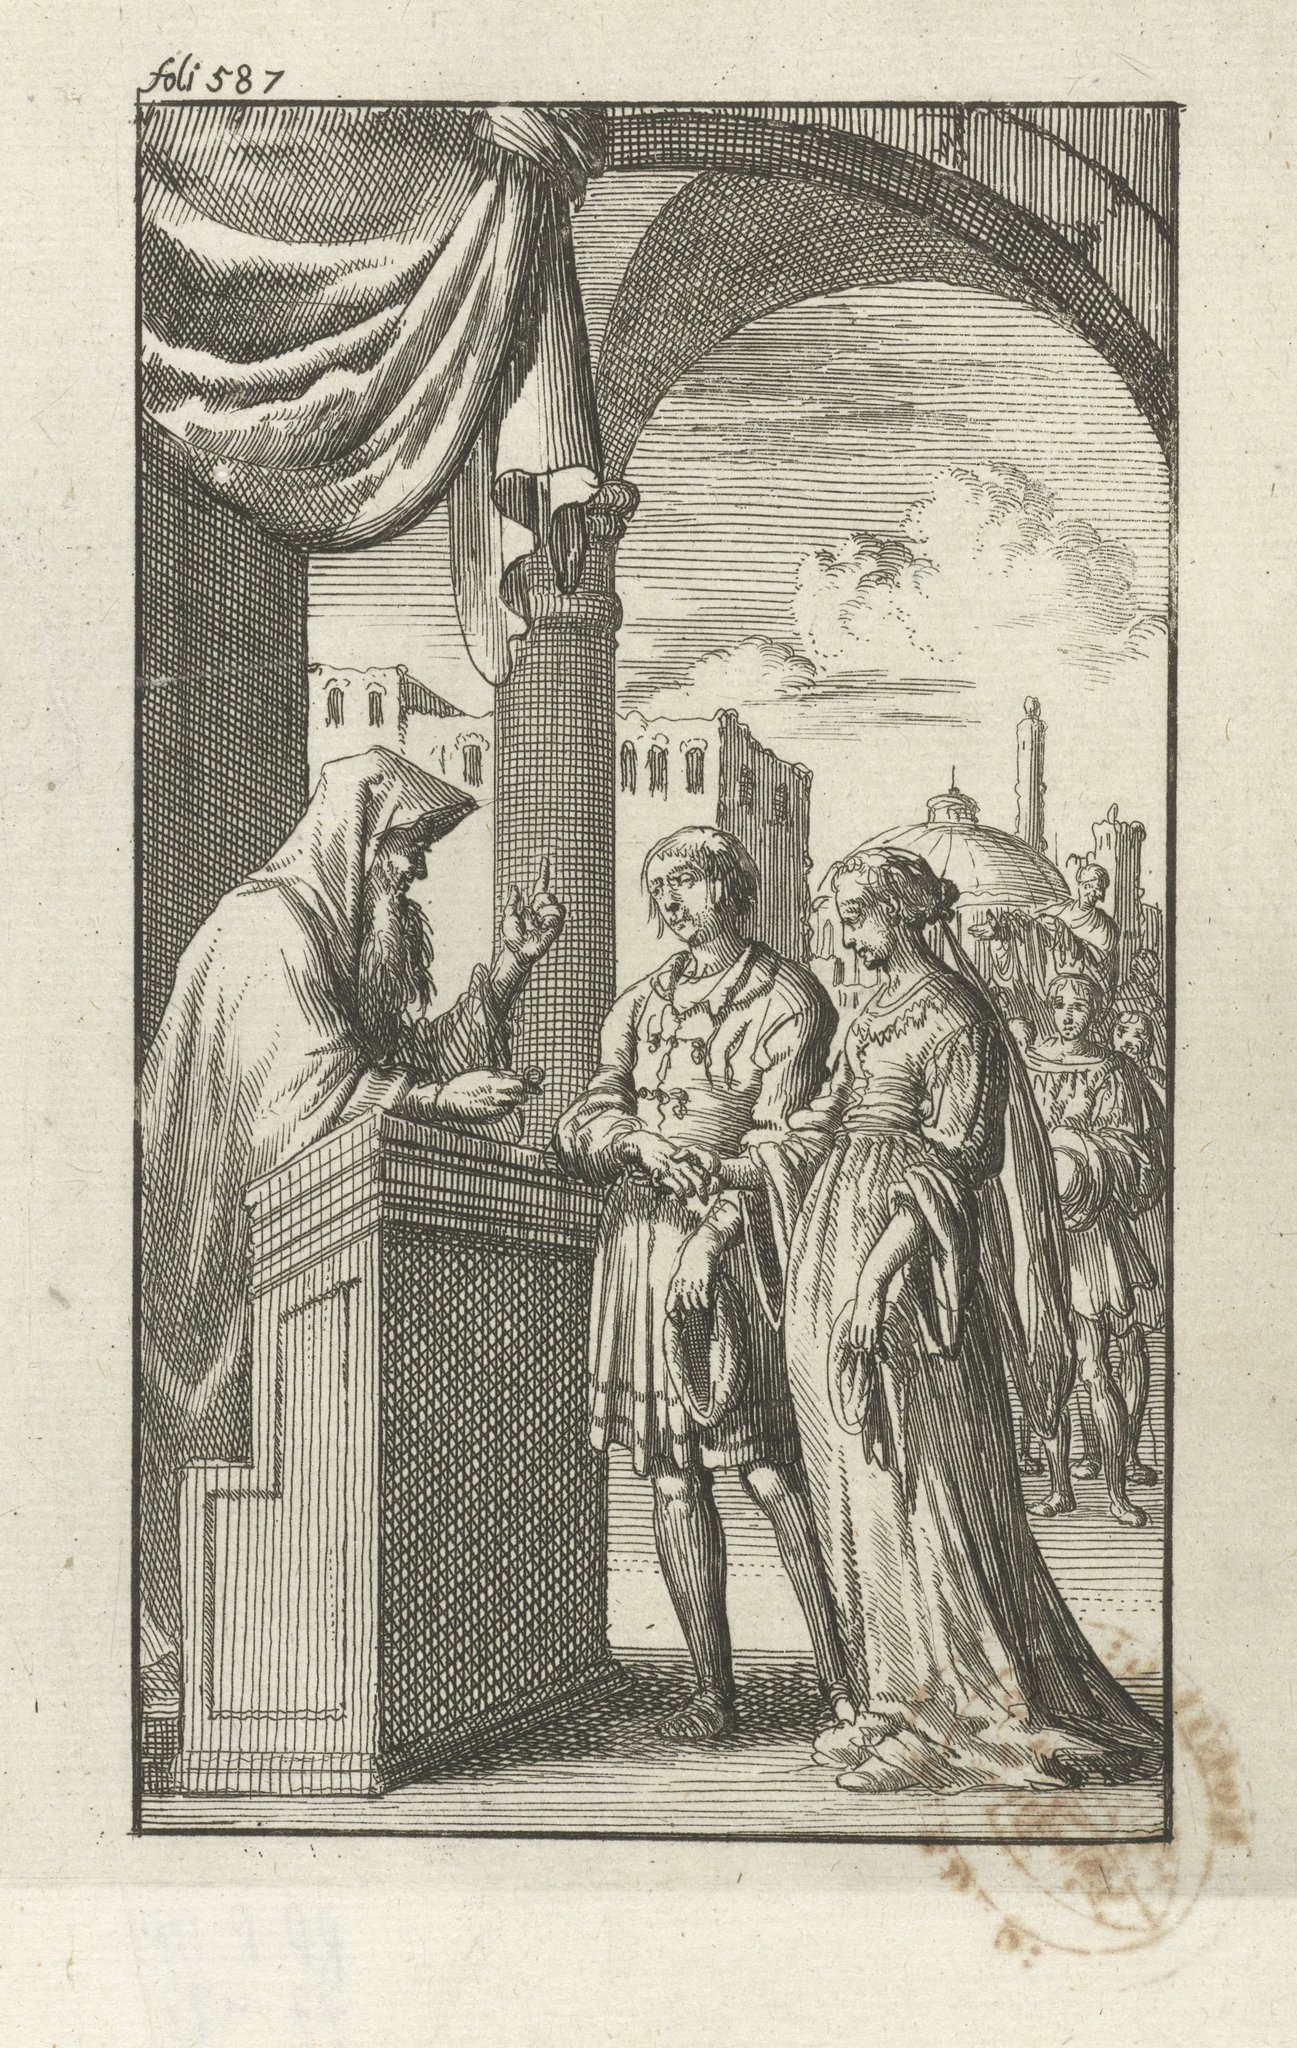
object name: print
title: Huwelijksinzegening door een joodse priester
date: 1685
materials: paper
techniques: etching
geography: amsterdam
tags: 'kiddushin', jewish wedding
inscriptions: collector's mark: Lugt 240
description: Illustratie uit: Hondorffius, Andreas. De tien geboden des Heeren. Amsterdam: Jan Bouman, 1685.